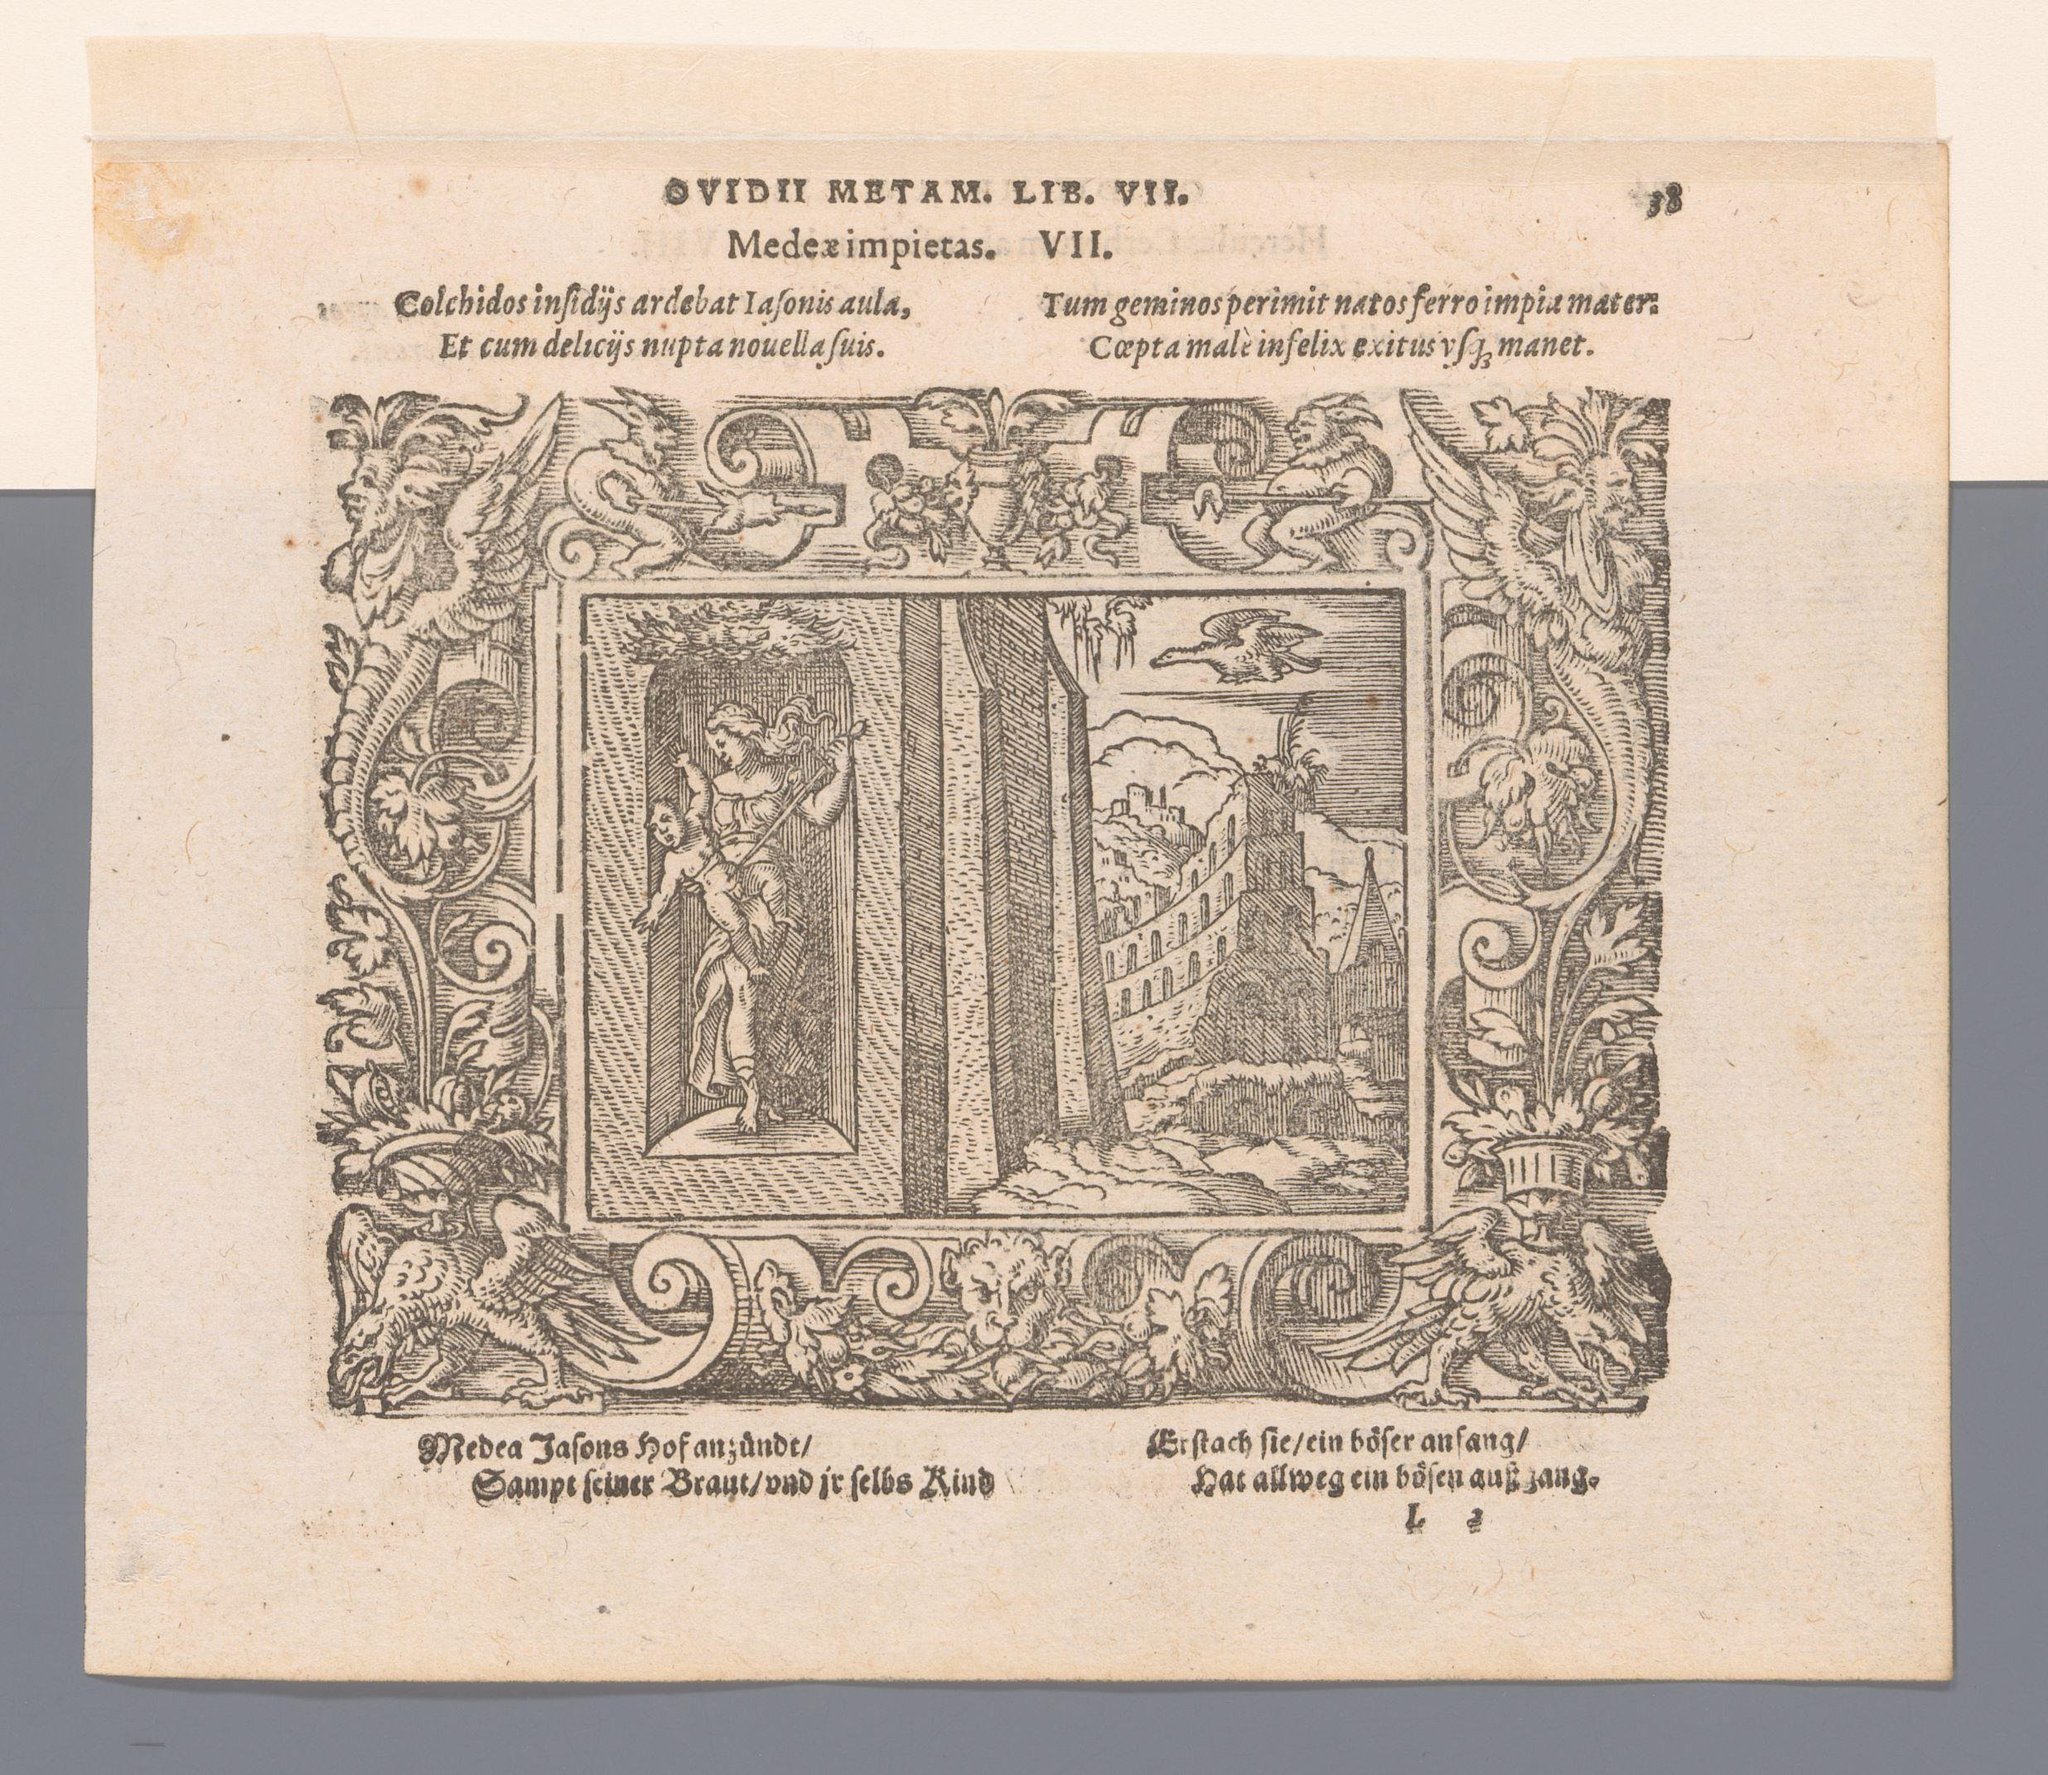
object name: book illustration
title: Medea doodt een van haar kinderen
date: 1569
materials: paper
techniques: letterpress printing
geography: frankfurt am main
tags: scrollwork, strapwork ~ ornament, medea kills her two children; she flees from corinth in a chariot drawn by winged dragons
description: Illustratie bij de Metamorfosen van Ovidius, afkomstig uit de publicatie: Posthius, Johannes. Tetrasticha in Ovidii metam. Frankfurt am Main: Georg Rab en Sigmund Feyerabend en erven Weigand Han, 1569. De voorstellingen en ornamentranden van deze boekillustraties zijn van twee aparte blokken gedrukt. Beide werden afzonderlijk van elkaar ook gebruikt voor andere publicaties, en de ornamentranden werden eveneens binnen deze publicatie meerdere keren gebruikt.